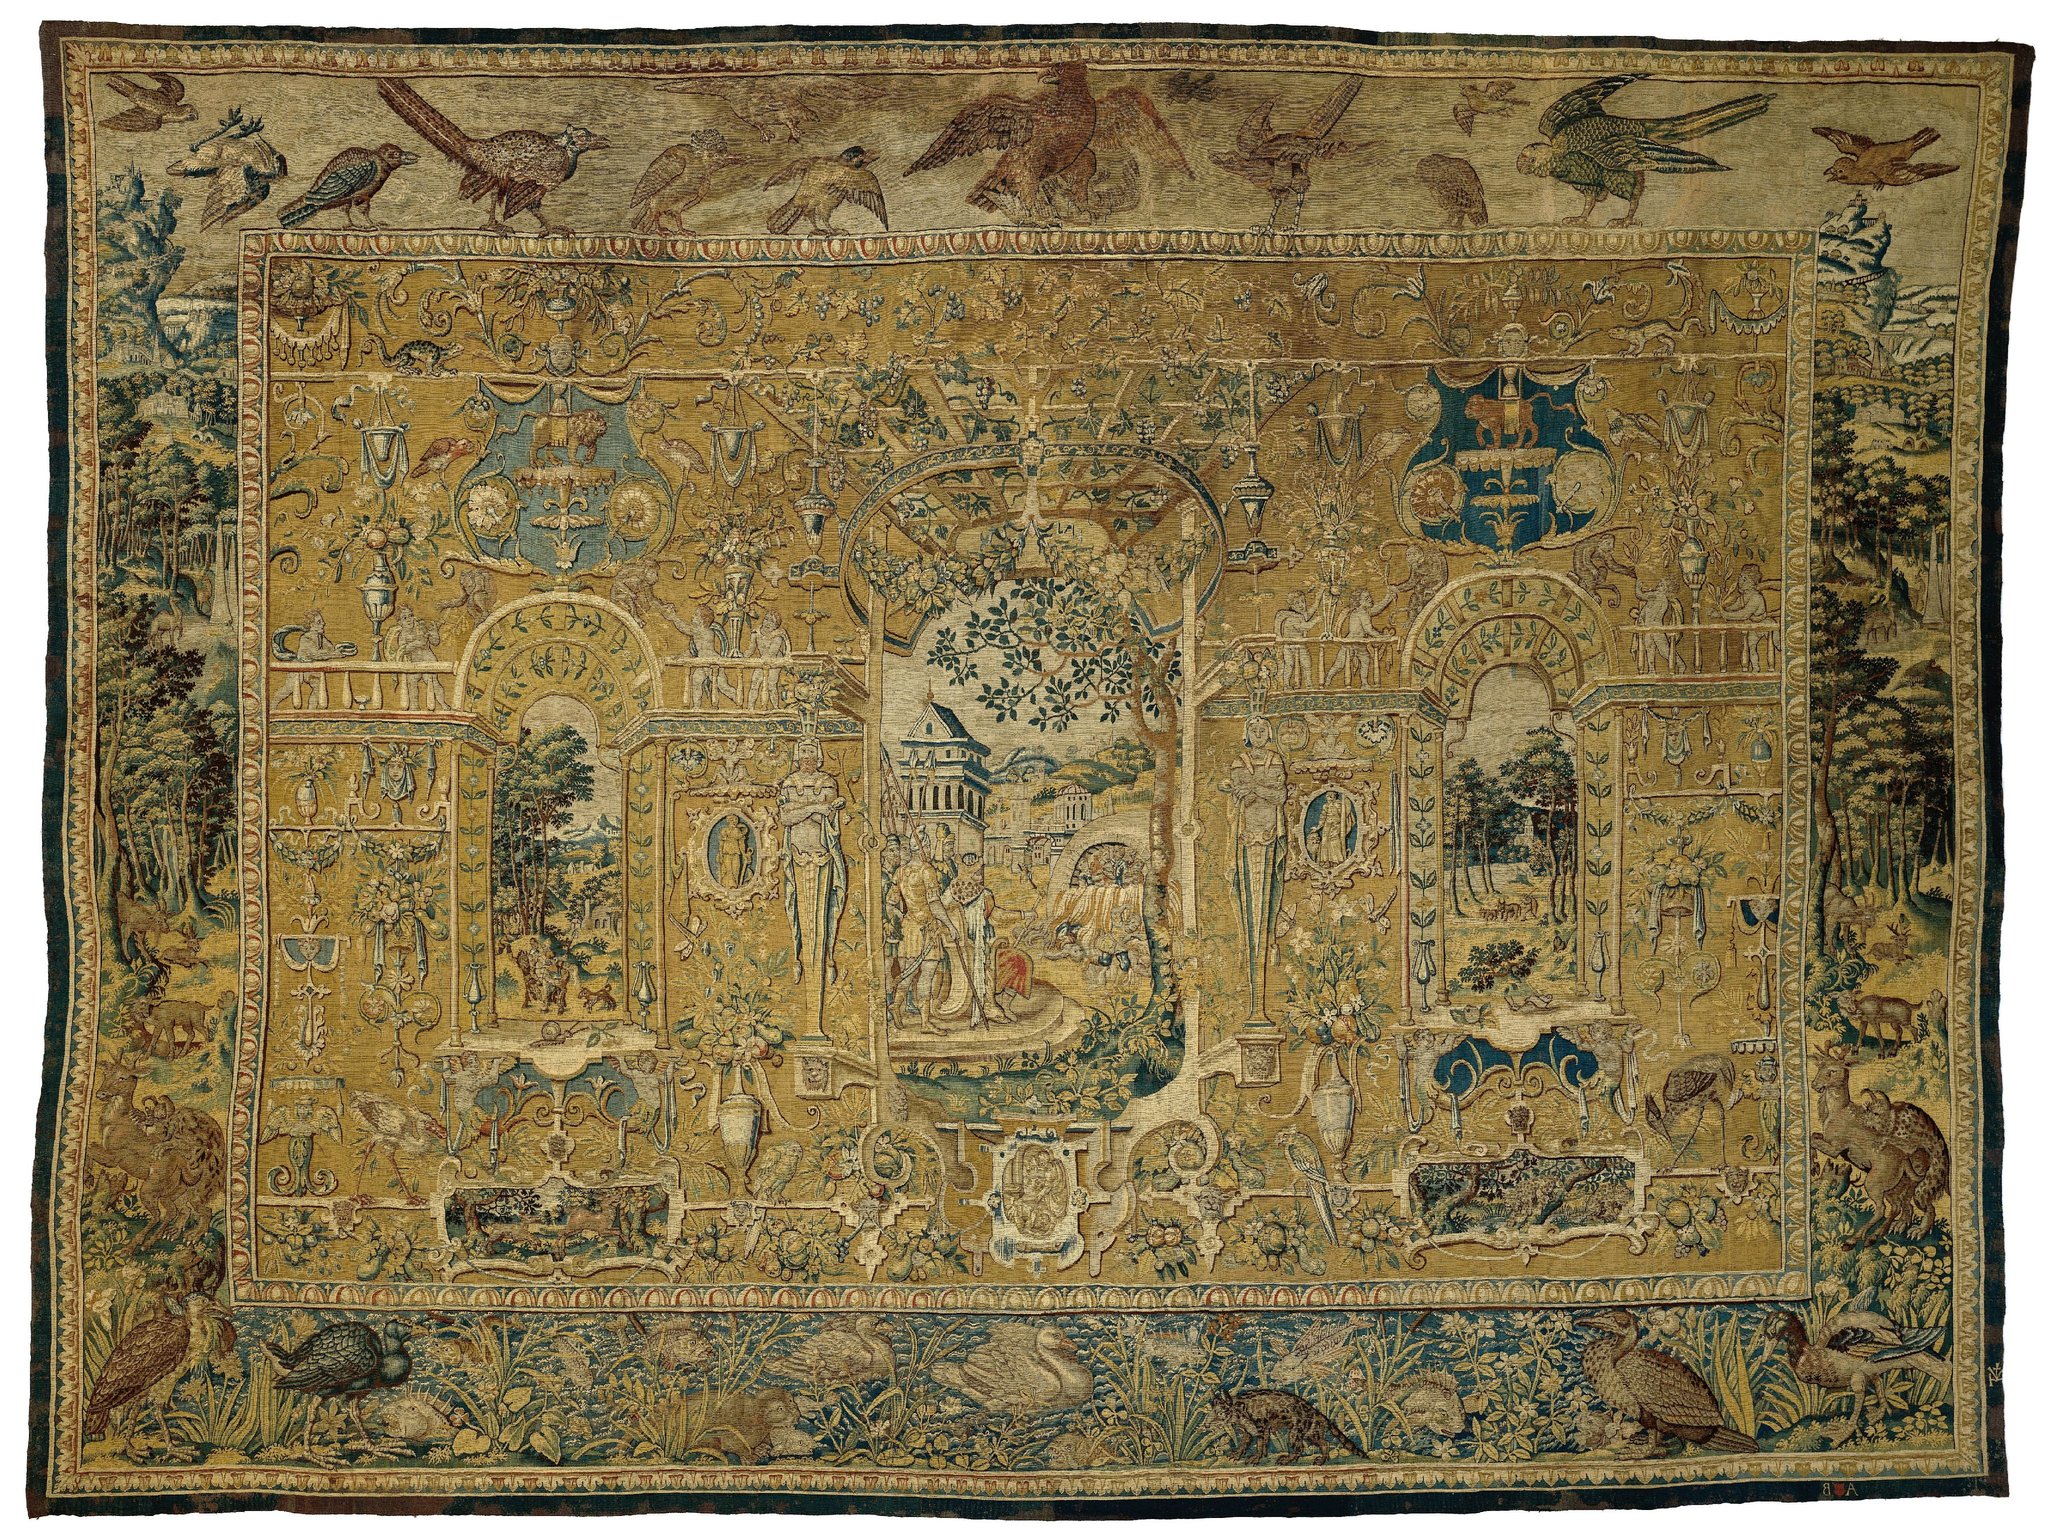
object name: tapestry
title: Groteskentapijt met Nebukadnezar en de drie jongelingen in het vuur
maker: joost van herseele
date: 1580-1585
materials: silk, wool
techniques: tapestry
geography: antwerp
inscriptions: mark: ‘weversmerk’, mark: ‘B A waartussen schild’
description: Grotesque tapestry with the story of Nebuchadnezzar and the three Hebrews in the fiery furnace (Daniël 3:25). Marked B A for Brabant-Antwerp. Monogram J V H probably for Joost van Herseele. Antwerp, ca. 1565 - 1580. Wool and silk. Given by the Commission for Photographic Sales 1954.